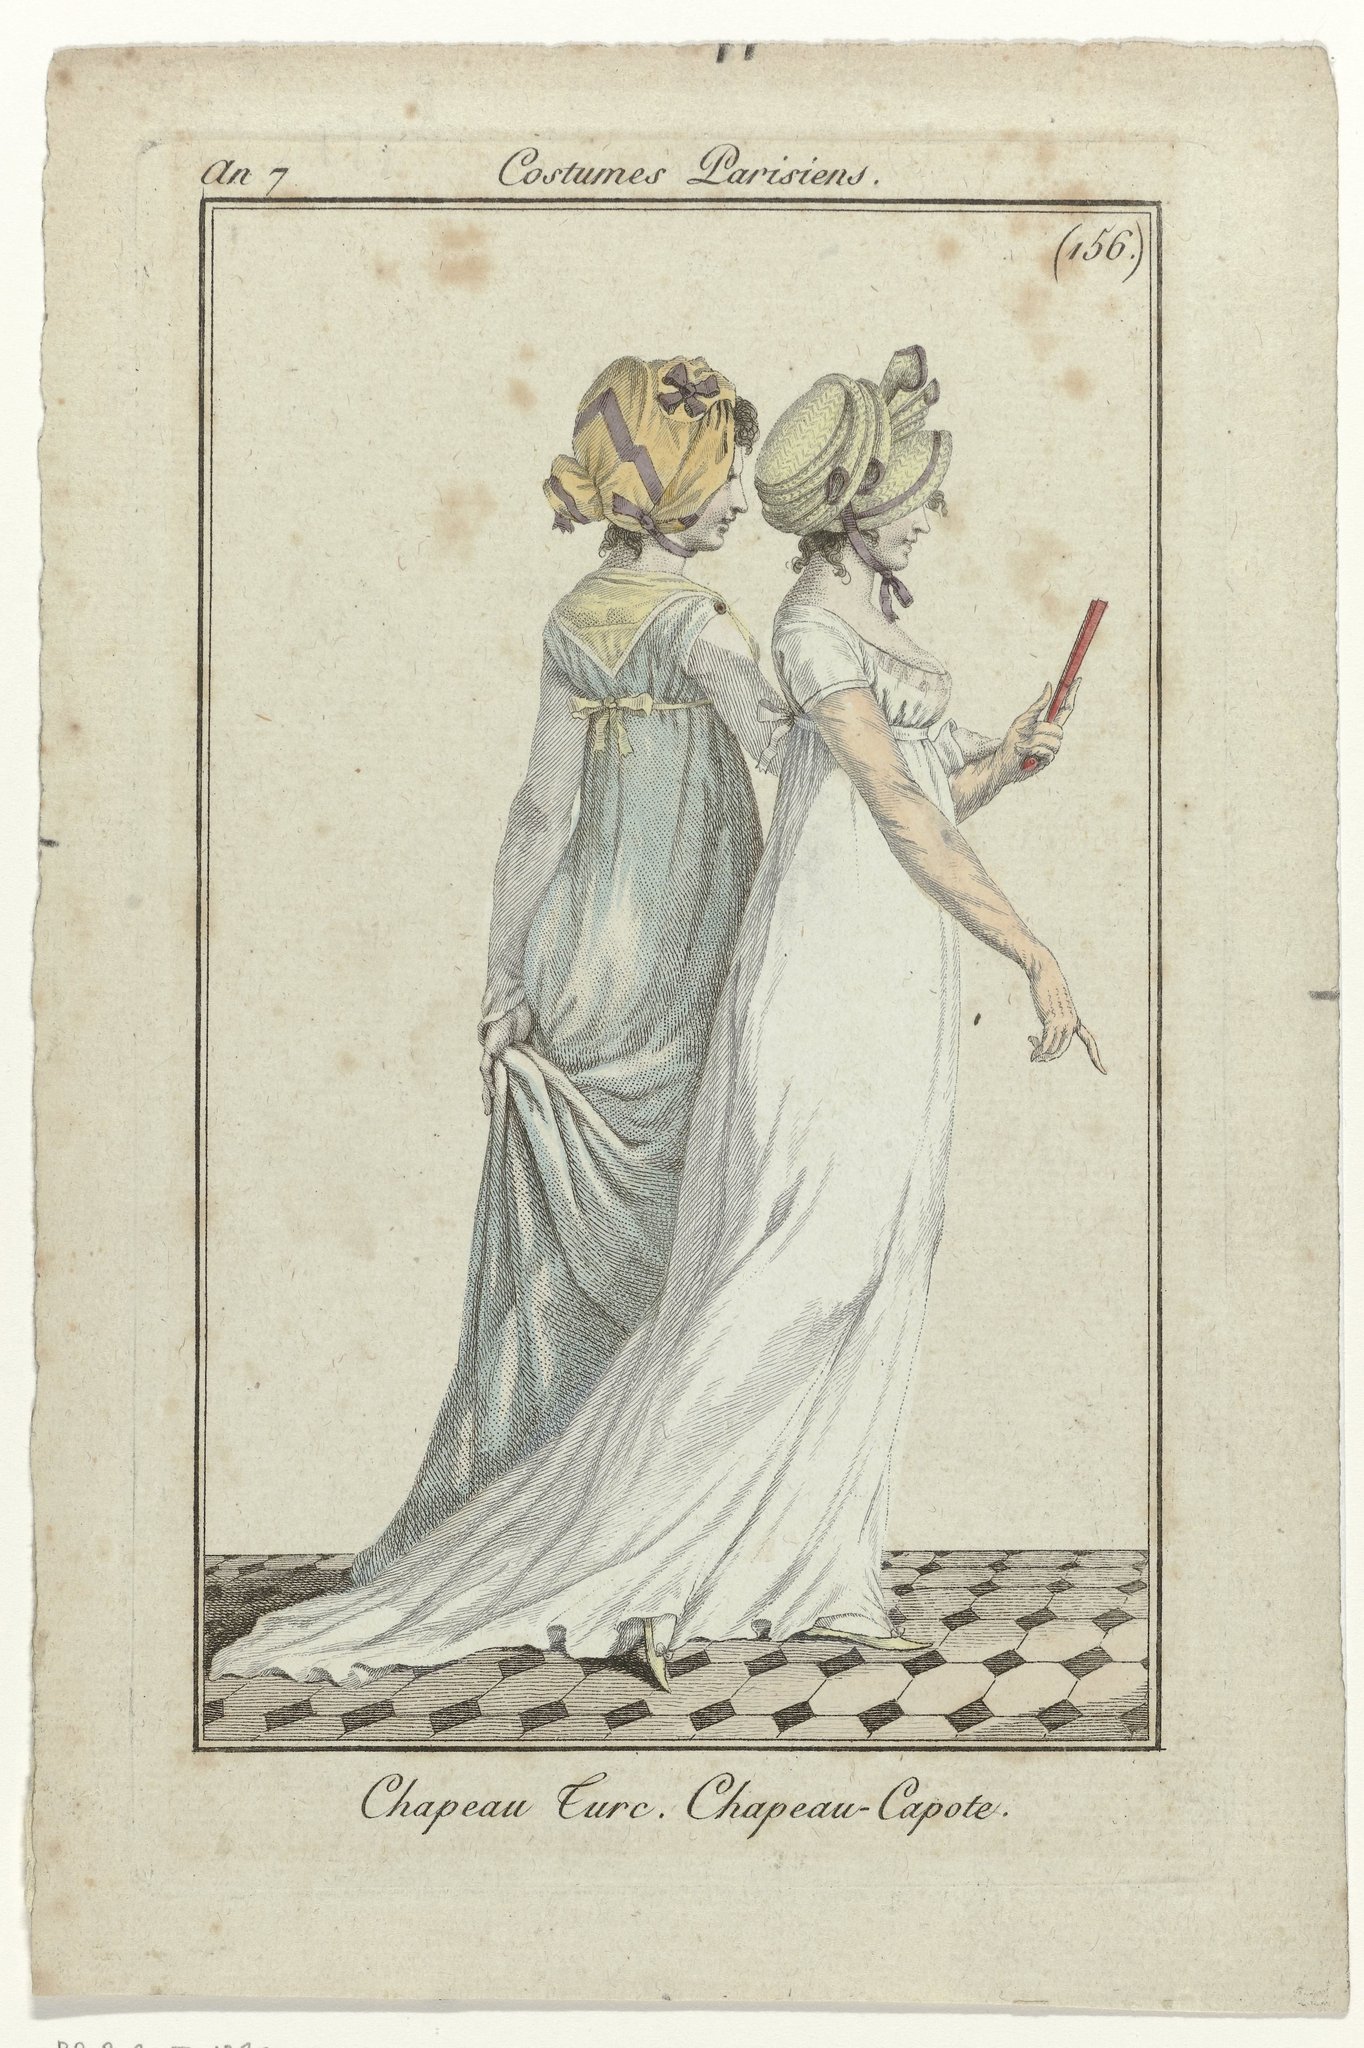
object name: fashion print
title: Journal des Dames et des Modes, Costume Parisien, 6 septembre 1799, An 7 (156) : Chapeau Turc (...)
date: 1799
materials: paper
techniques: engraving, hand coloring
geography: paris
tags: head-gear (capote) (+ women's clothes), gloves, mittens (long gloves) (+ women's clothes), fashion plates, head-gear: hat (+ women's clothes), shoes, sandals (+ women's clothes), dress, gown (+ women's clothes), fan (+ women's clothes), piece of clothing covering the breast or décolleté (fichu) (+ women's clothes)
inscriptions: caption: ‘Chapeau Turc. Chapeau-Capote’, title: ‘Costume Parisien.’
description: 'Chapeau Turc' en 'Chapeau-Capote'. Links: japon met lange mouwen. Fichu, op de rug vastgestrikt. Rechts: japon met korte mouwen en sleep. Verdere accessoires: zeer lange handschoenen, waaier, platte schoenen met puntige neuzen en strikken. De prent maakt deel uit van het modetijdschrift Journal des Dames et des Modes, uitgegeven door Pierre de la Mésangère, Parijs, 1797-1839.